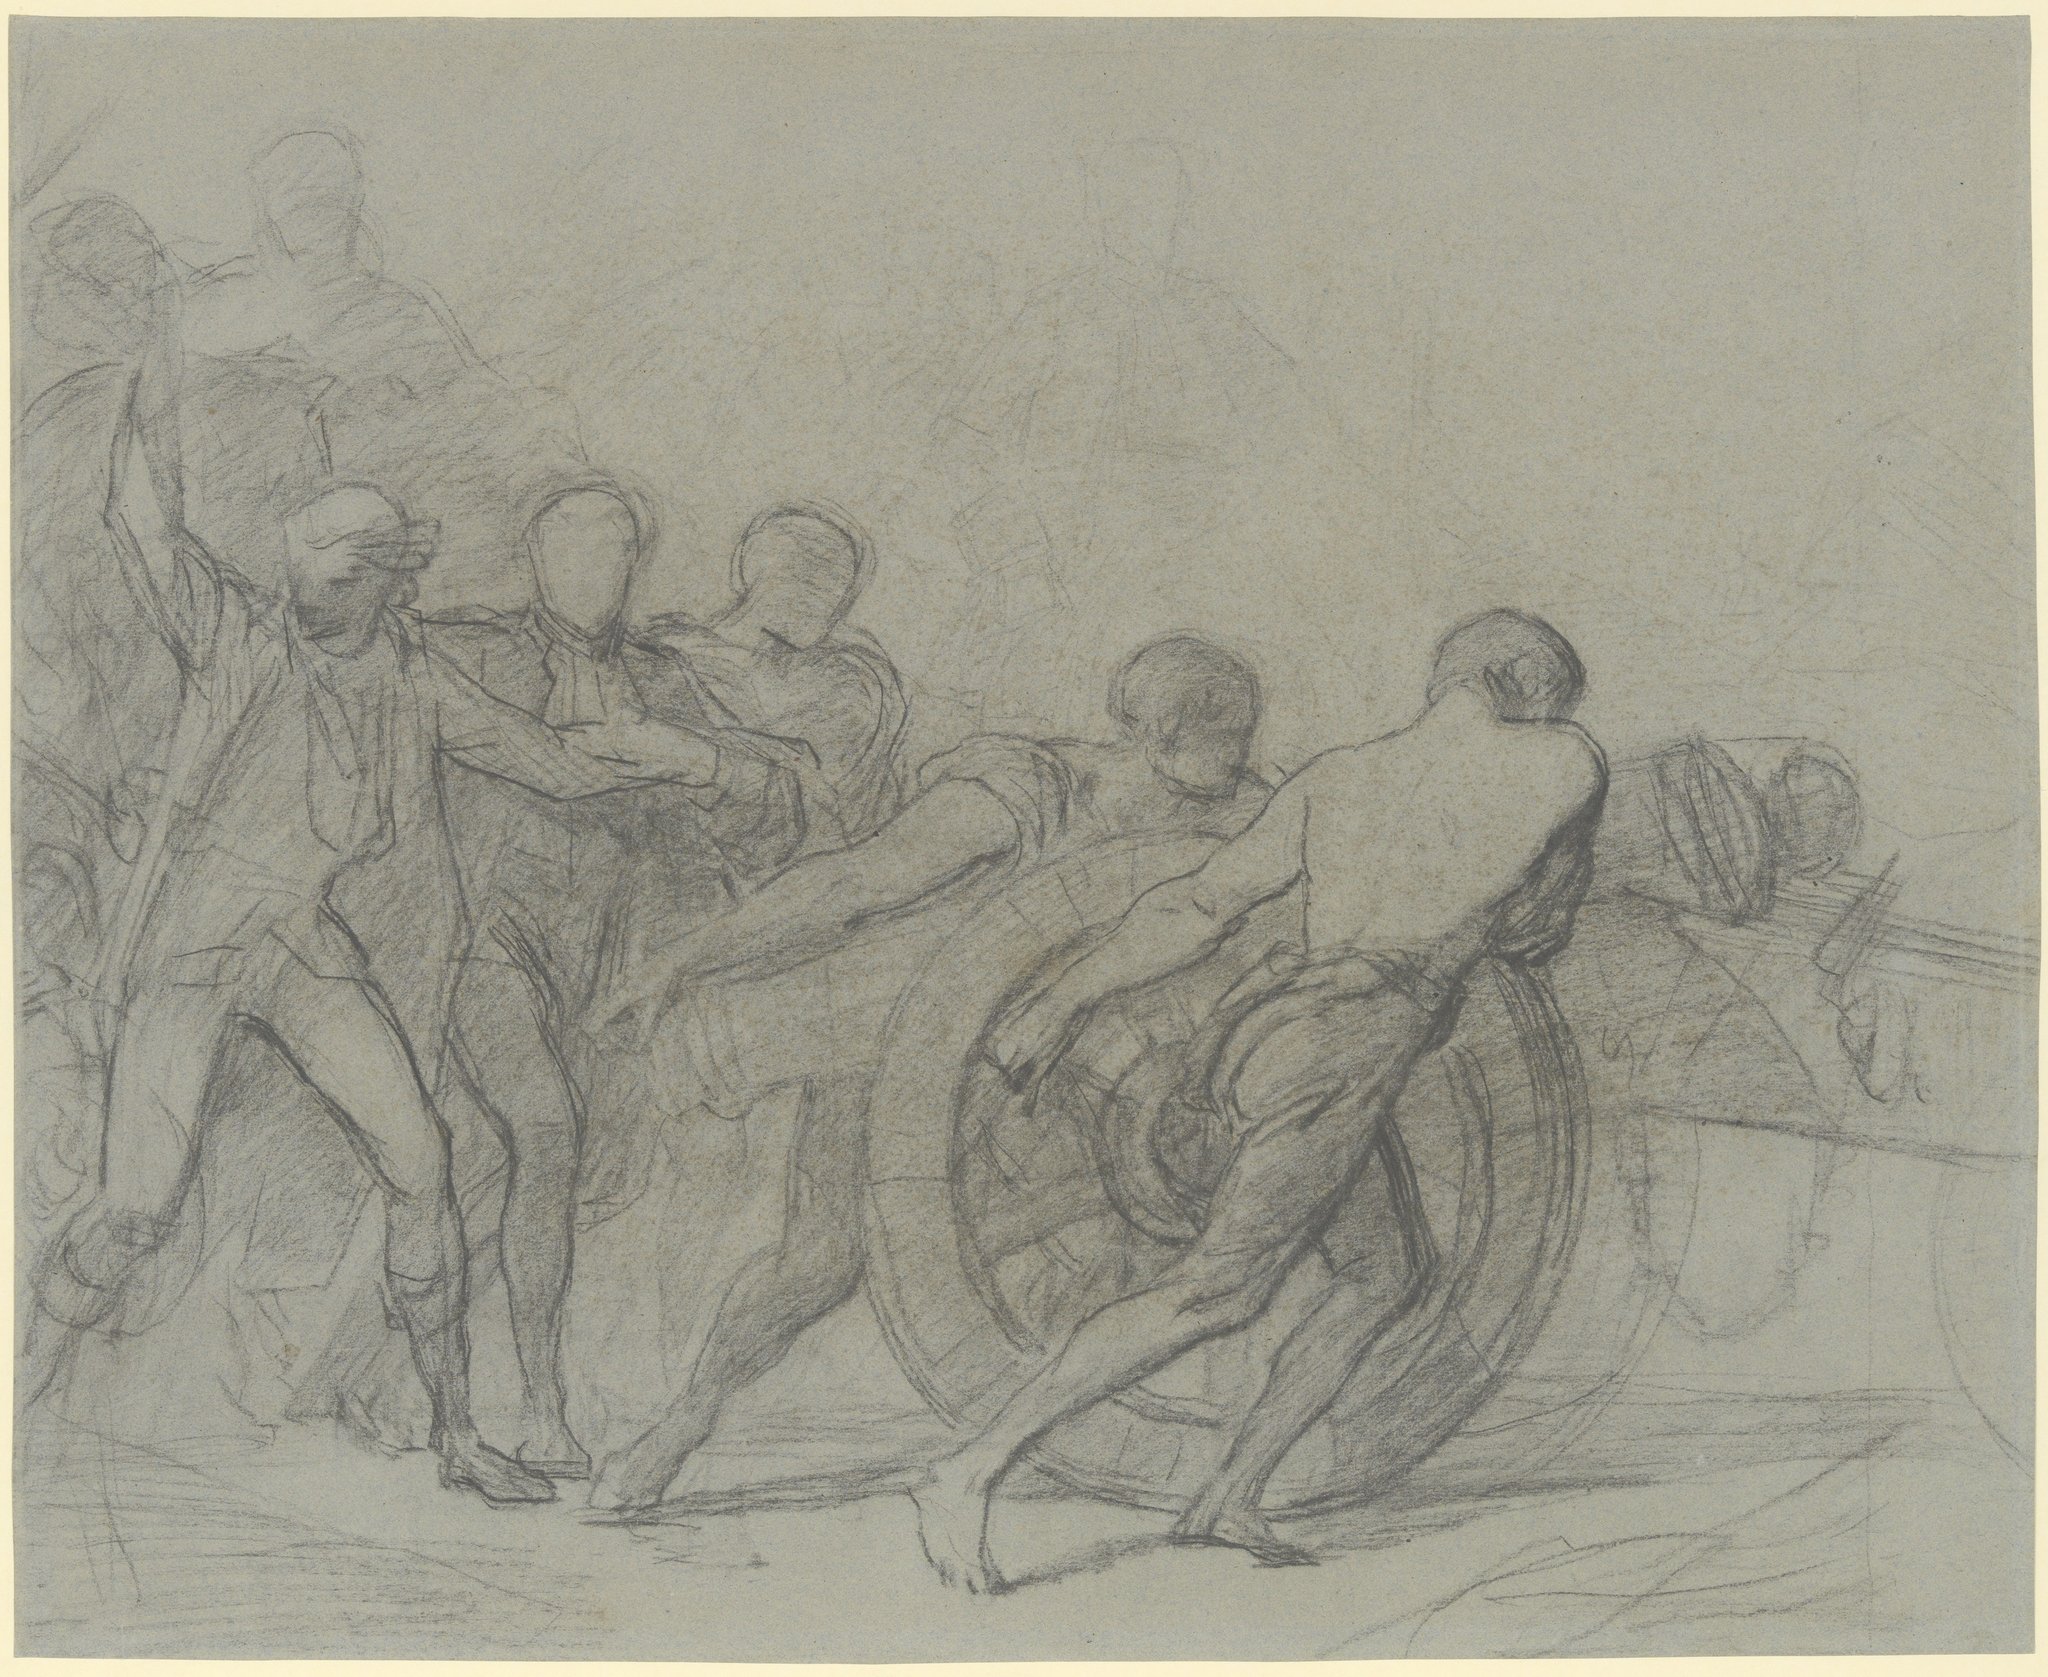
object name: drawing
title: Study for "The Enrollment of the Volunteers of 1792"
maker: thomas couture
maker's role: artist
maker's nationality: french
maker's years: 1815-1879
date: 1848-1851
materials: chalk, paper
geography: france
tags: cannons,men,working